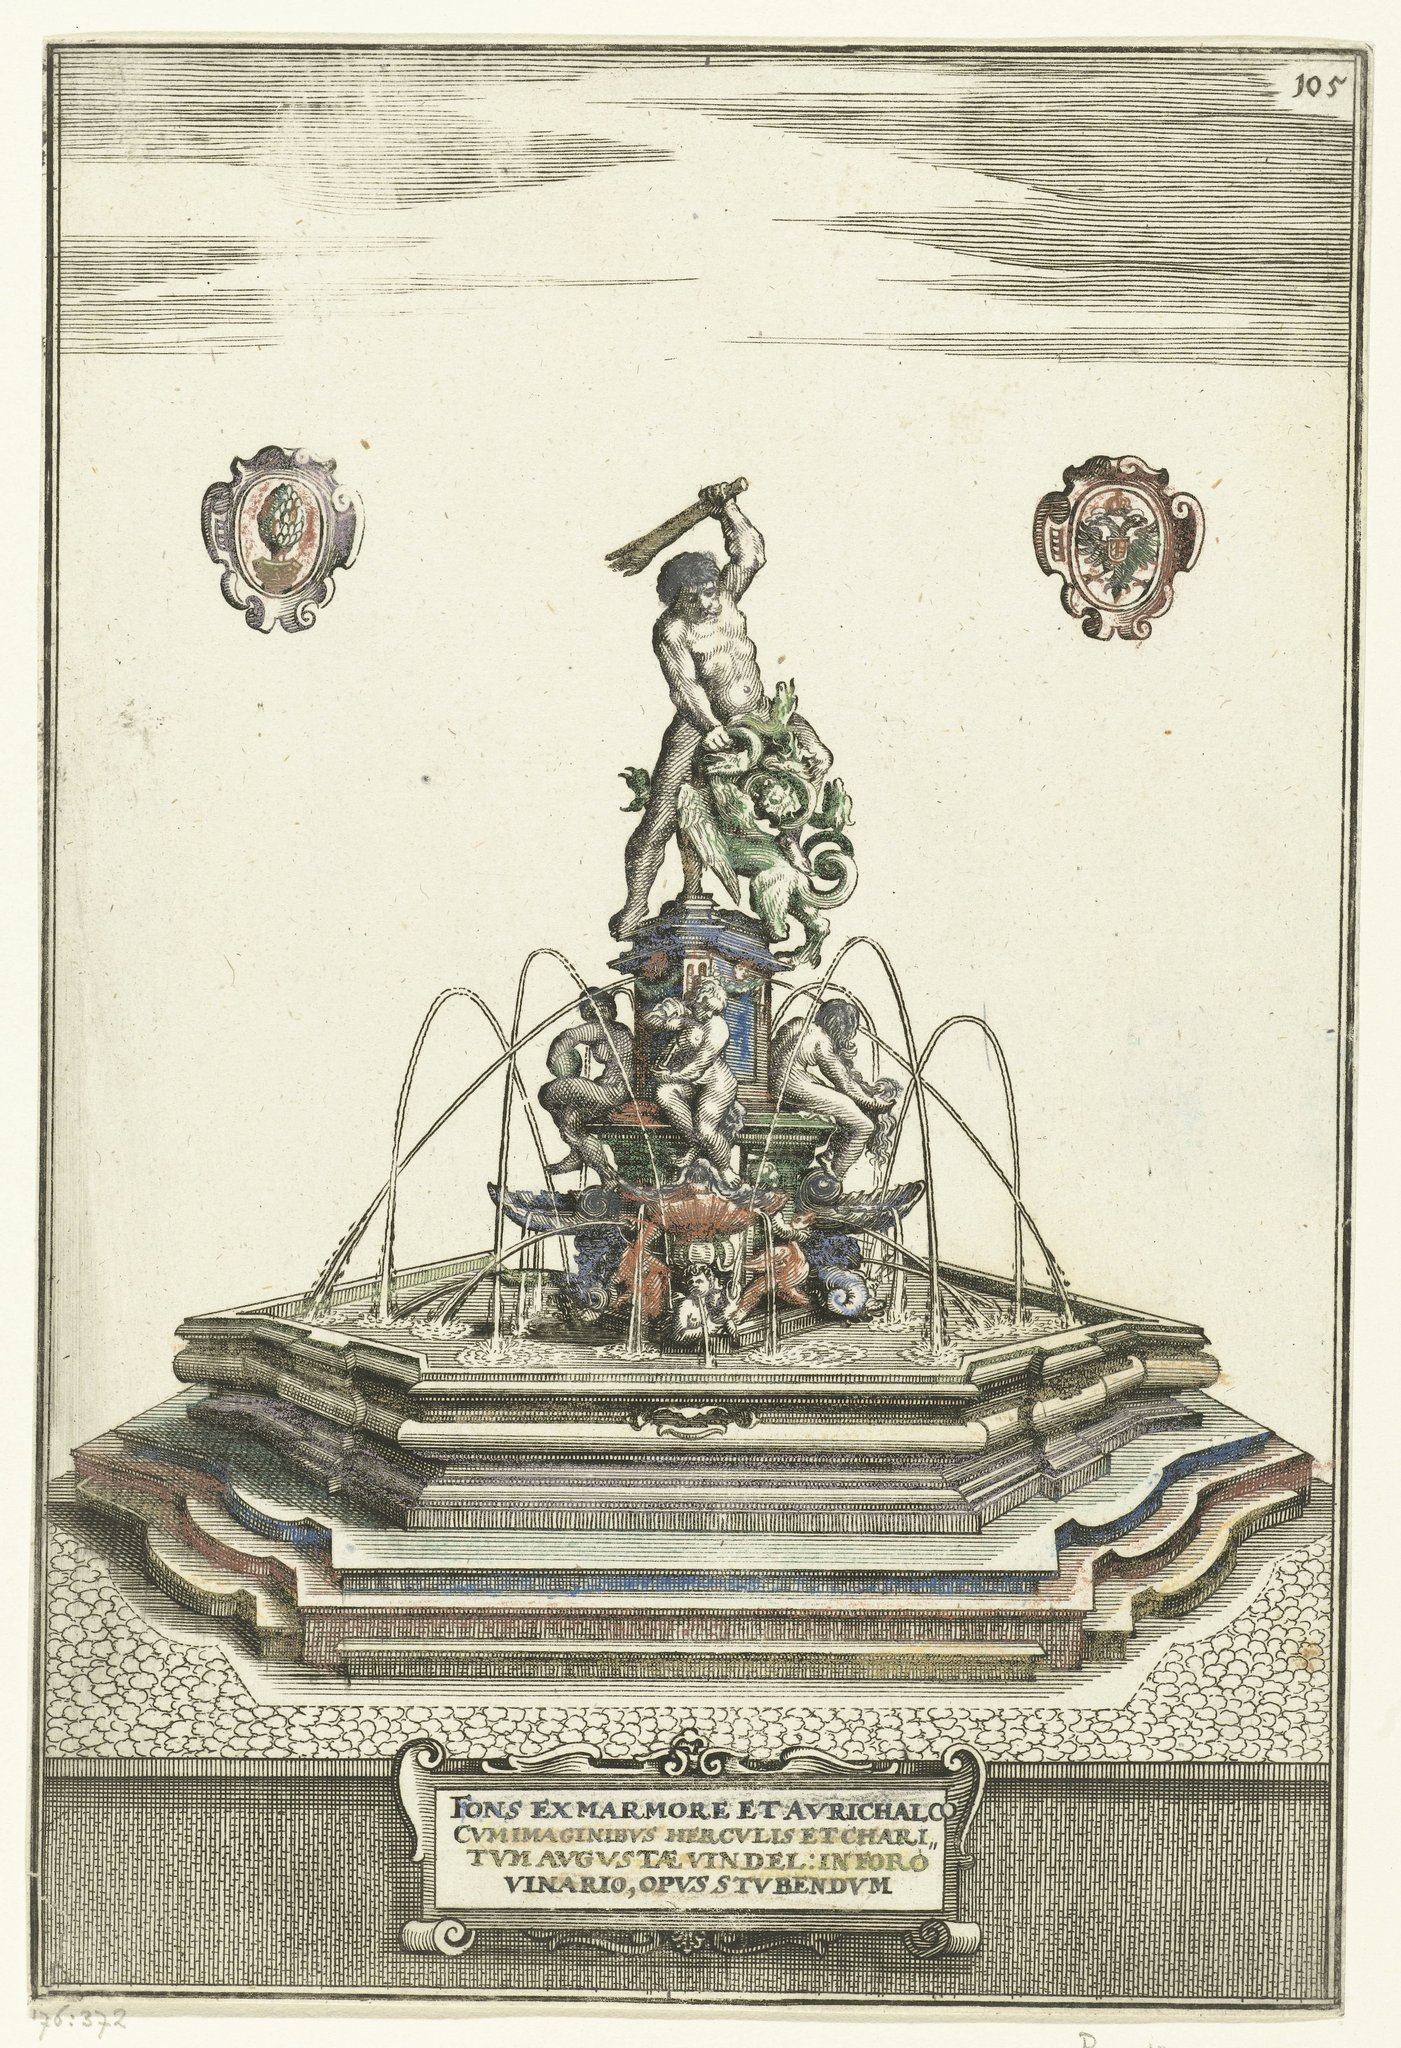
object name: ornament print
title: Zeshoekig bassin op verhoging met trappen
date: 1664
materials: paper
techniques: etching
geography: germany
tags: ornamental fountain (in village), augsburg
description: De Herculesfontein in de Maximilianstraße (voorheen Weinmarkt geheten) te Augsburg. In het bassin een bouwwerk versierd met schelpen en nimfen. Bovenaan doodt Hercules het monster Geryon. Blad 105 uit deel III van een serie bestaande uit 226 bladen, verdeeld over vier boeken, elk met een eigen titelblad.